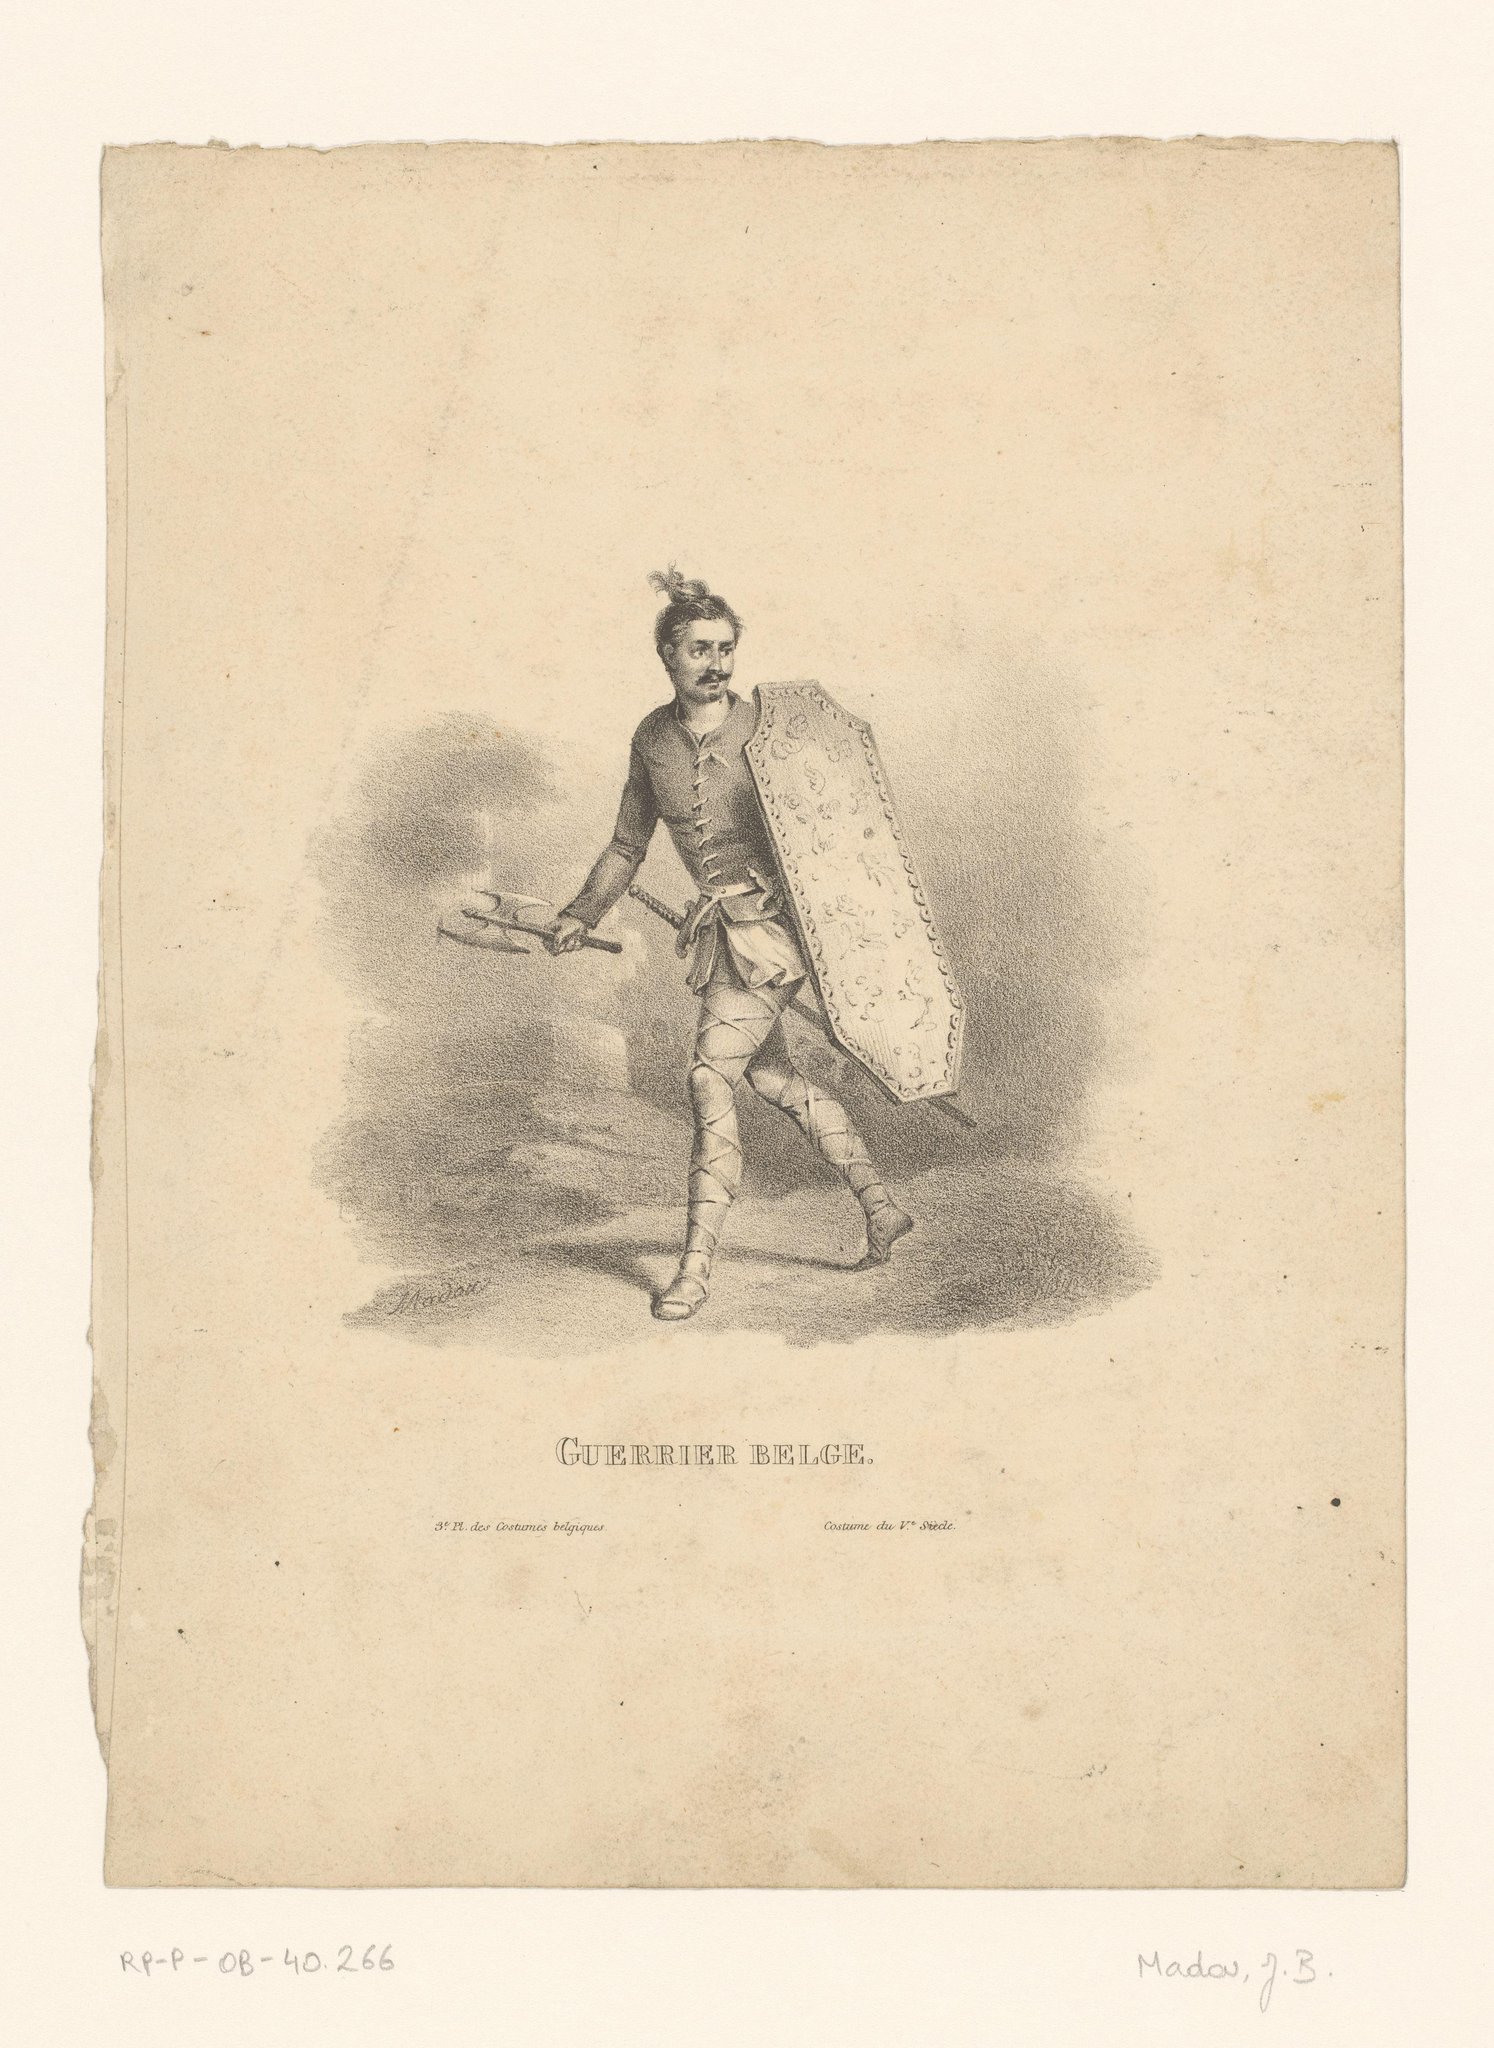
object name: book illustration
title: Belgische strijder met schild en bijl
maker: jean baptiste madou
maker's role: draughtsman, painter, print maker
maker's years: 1796-1877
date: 1830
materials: paper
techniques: lithograph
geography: brussels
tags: protective weapons: shield, adult man, (military) uniforms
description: Prent verschenen in: Costumes belgiques, anciens et modernes: militaires, civils et religieux. Brussel: Lith. royale de Jobard, 1830.